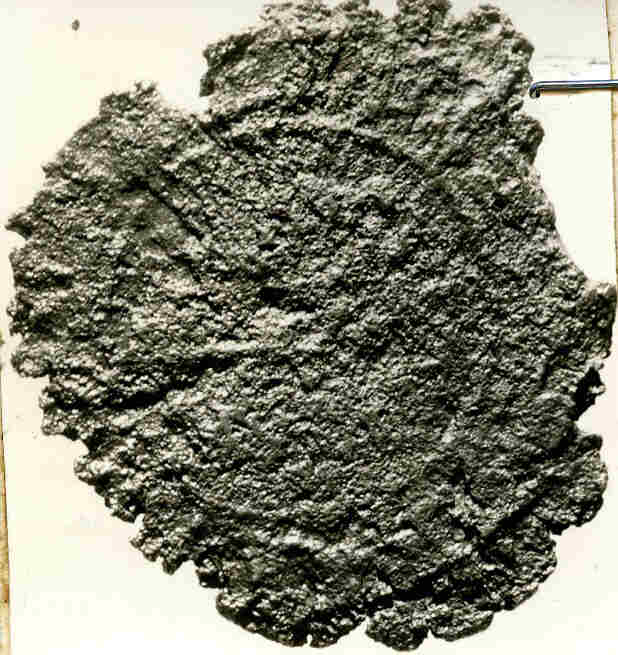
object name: coin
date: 701-800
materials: copper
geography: iran